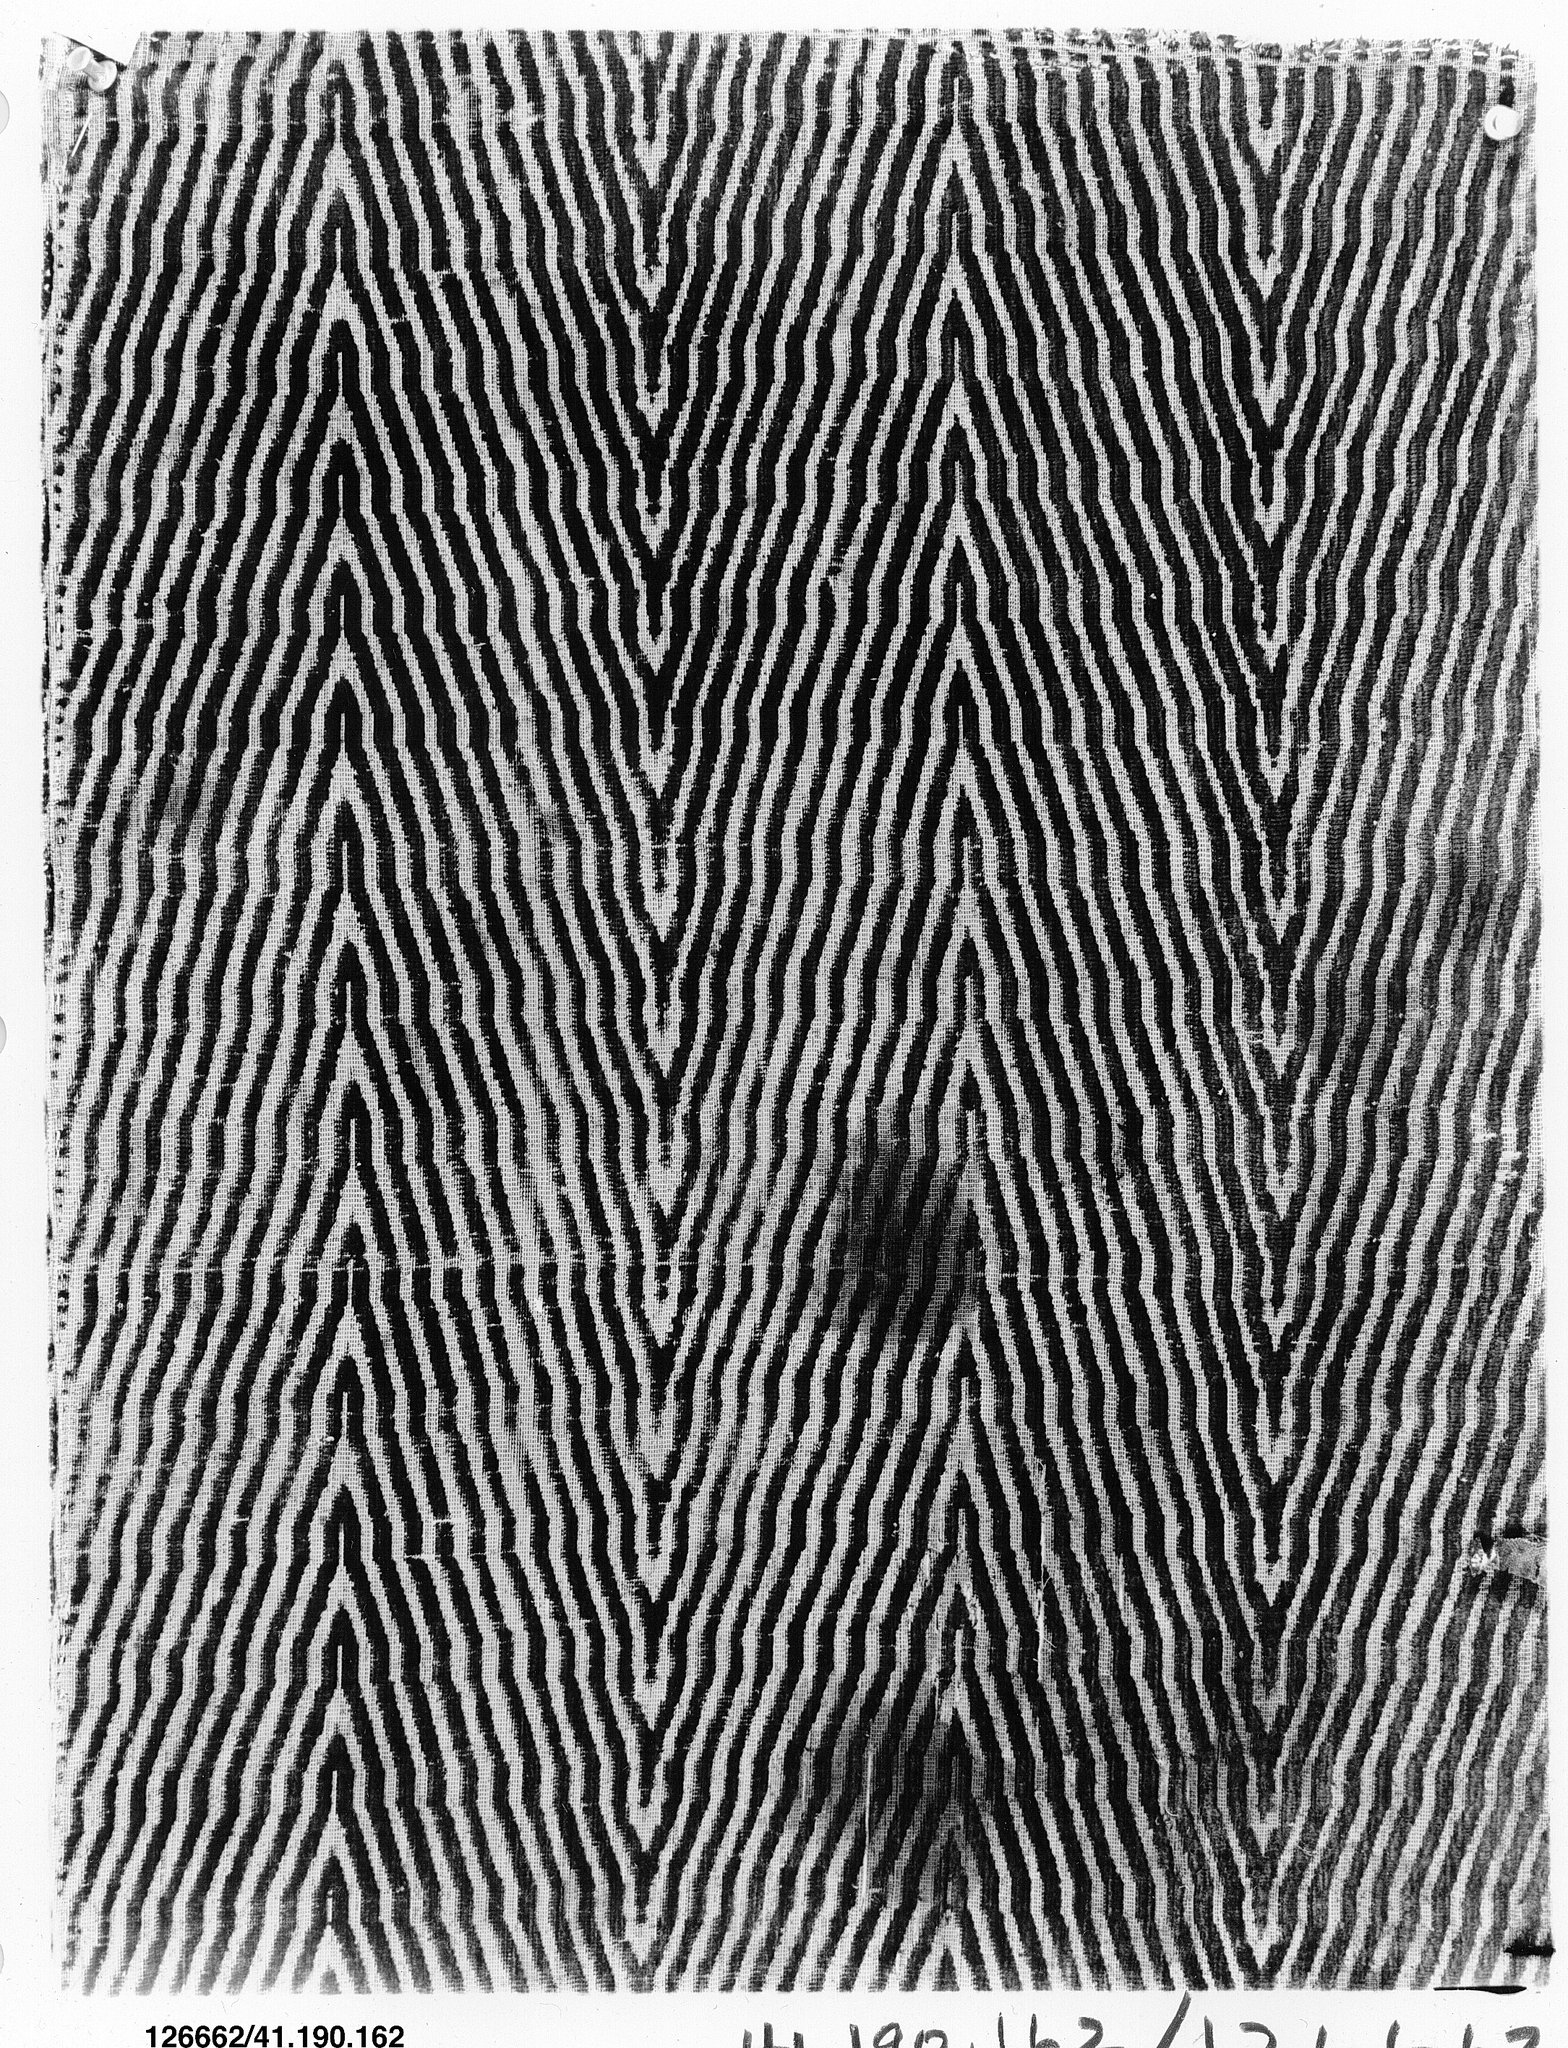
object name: piece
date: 1734-1766